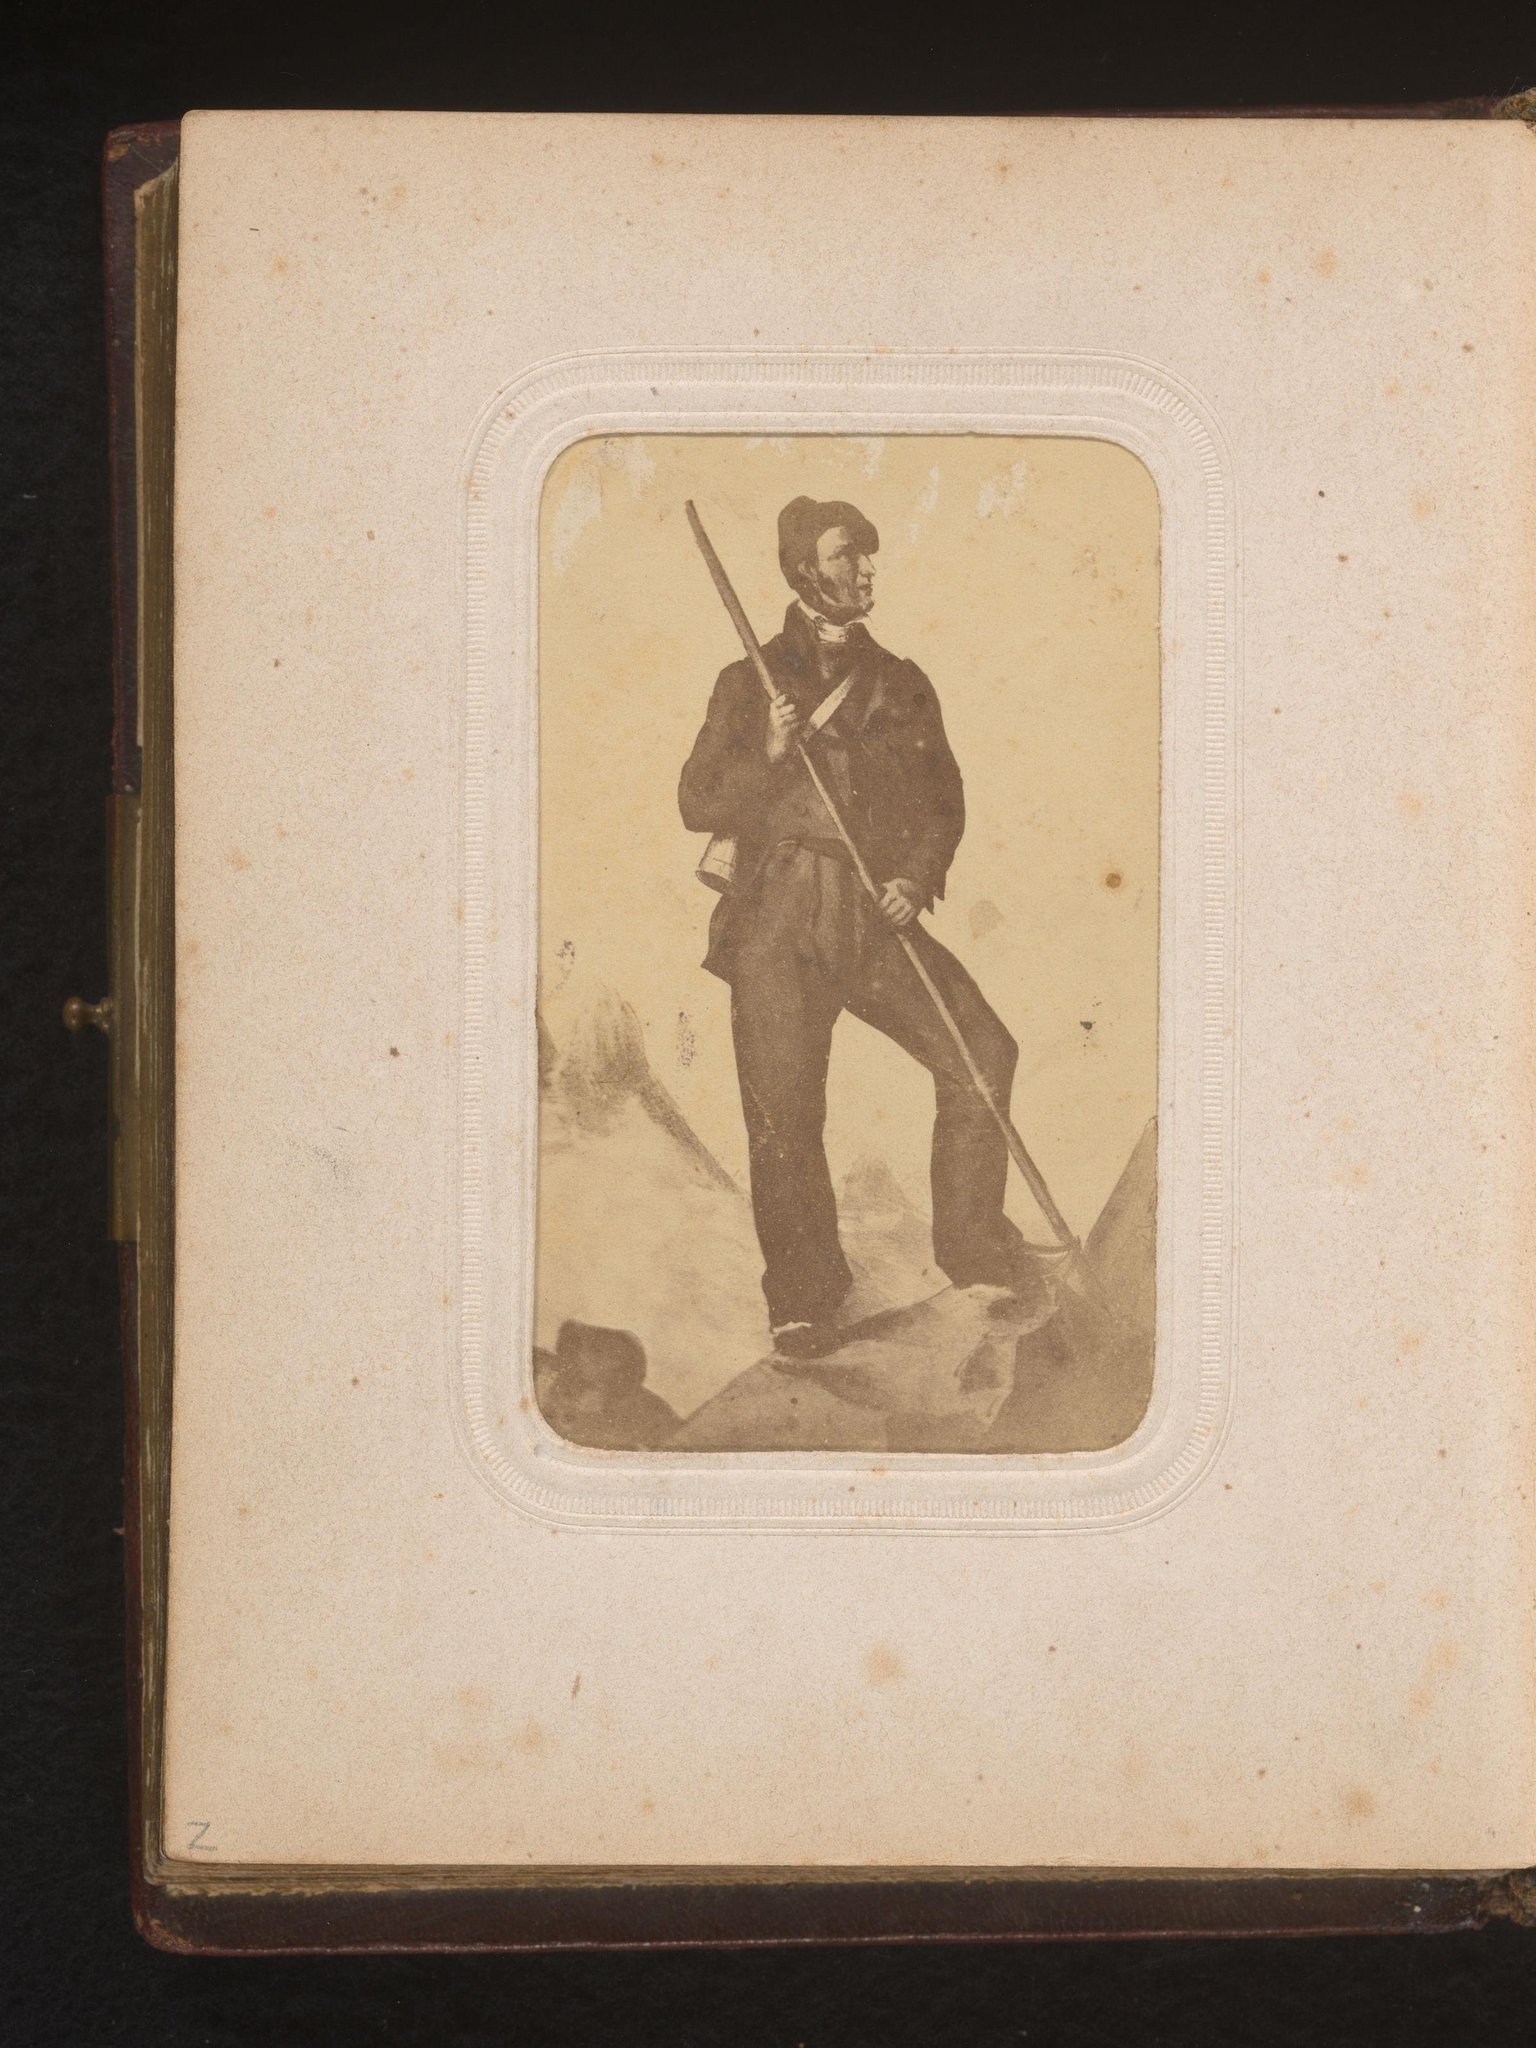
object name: reproduction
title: Fotoreproductie van een man op de top van een berg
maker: Anonymous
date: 1860-1900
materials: cardboard, photographic support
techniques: albumen print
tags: mountain climbing, mountaineering, mountain-top, peak, adult man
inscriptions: annotation: ‘Charles, guide de Ramond, au Pyrénées’